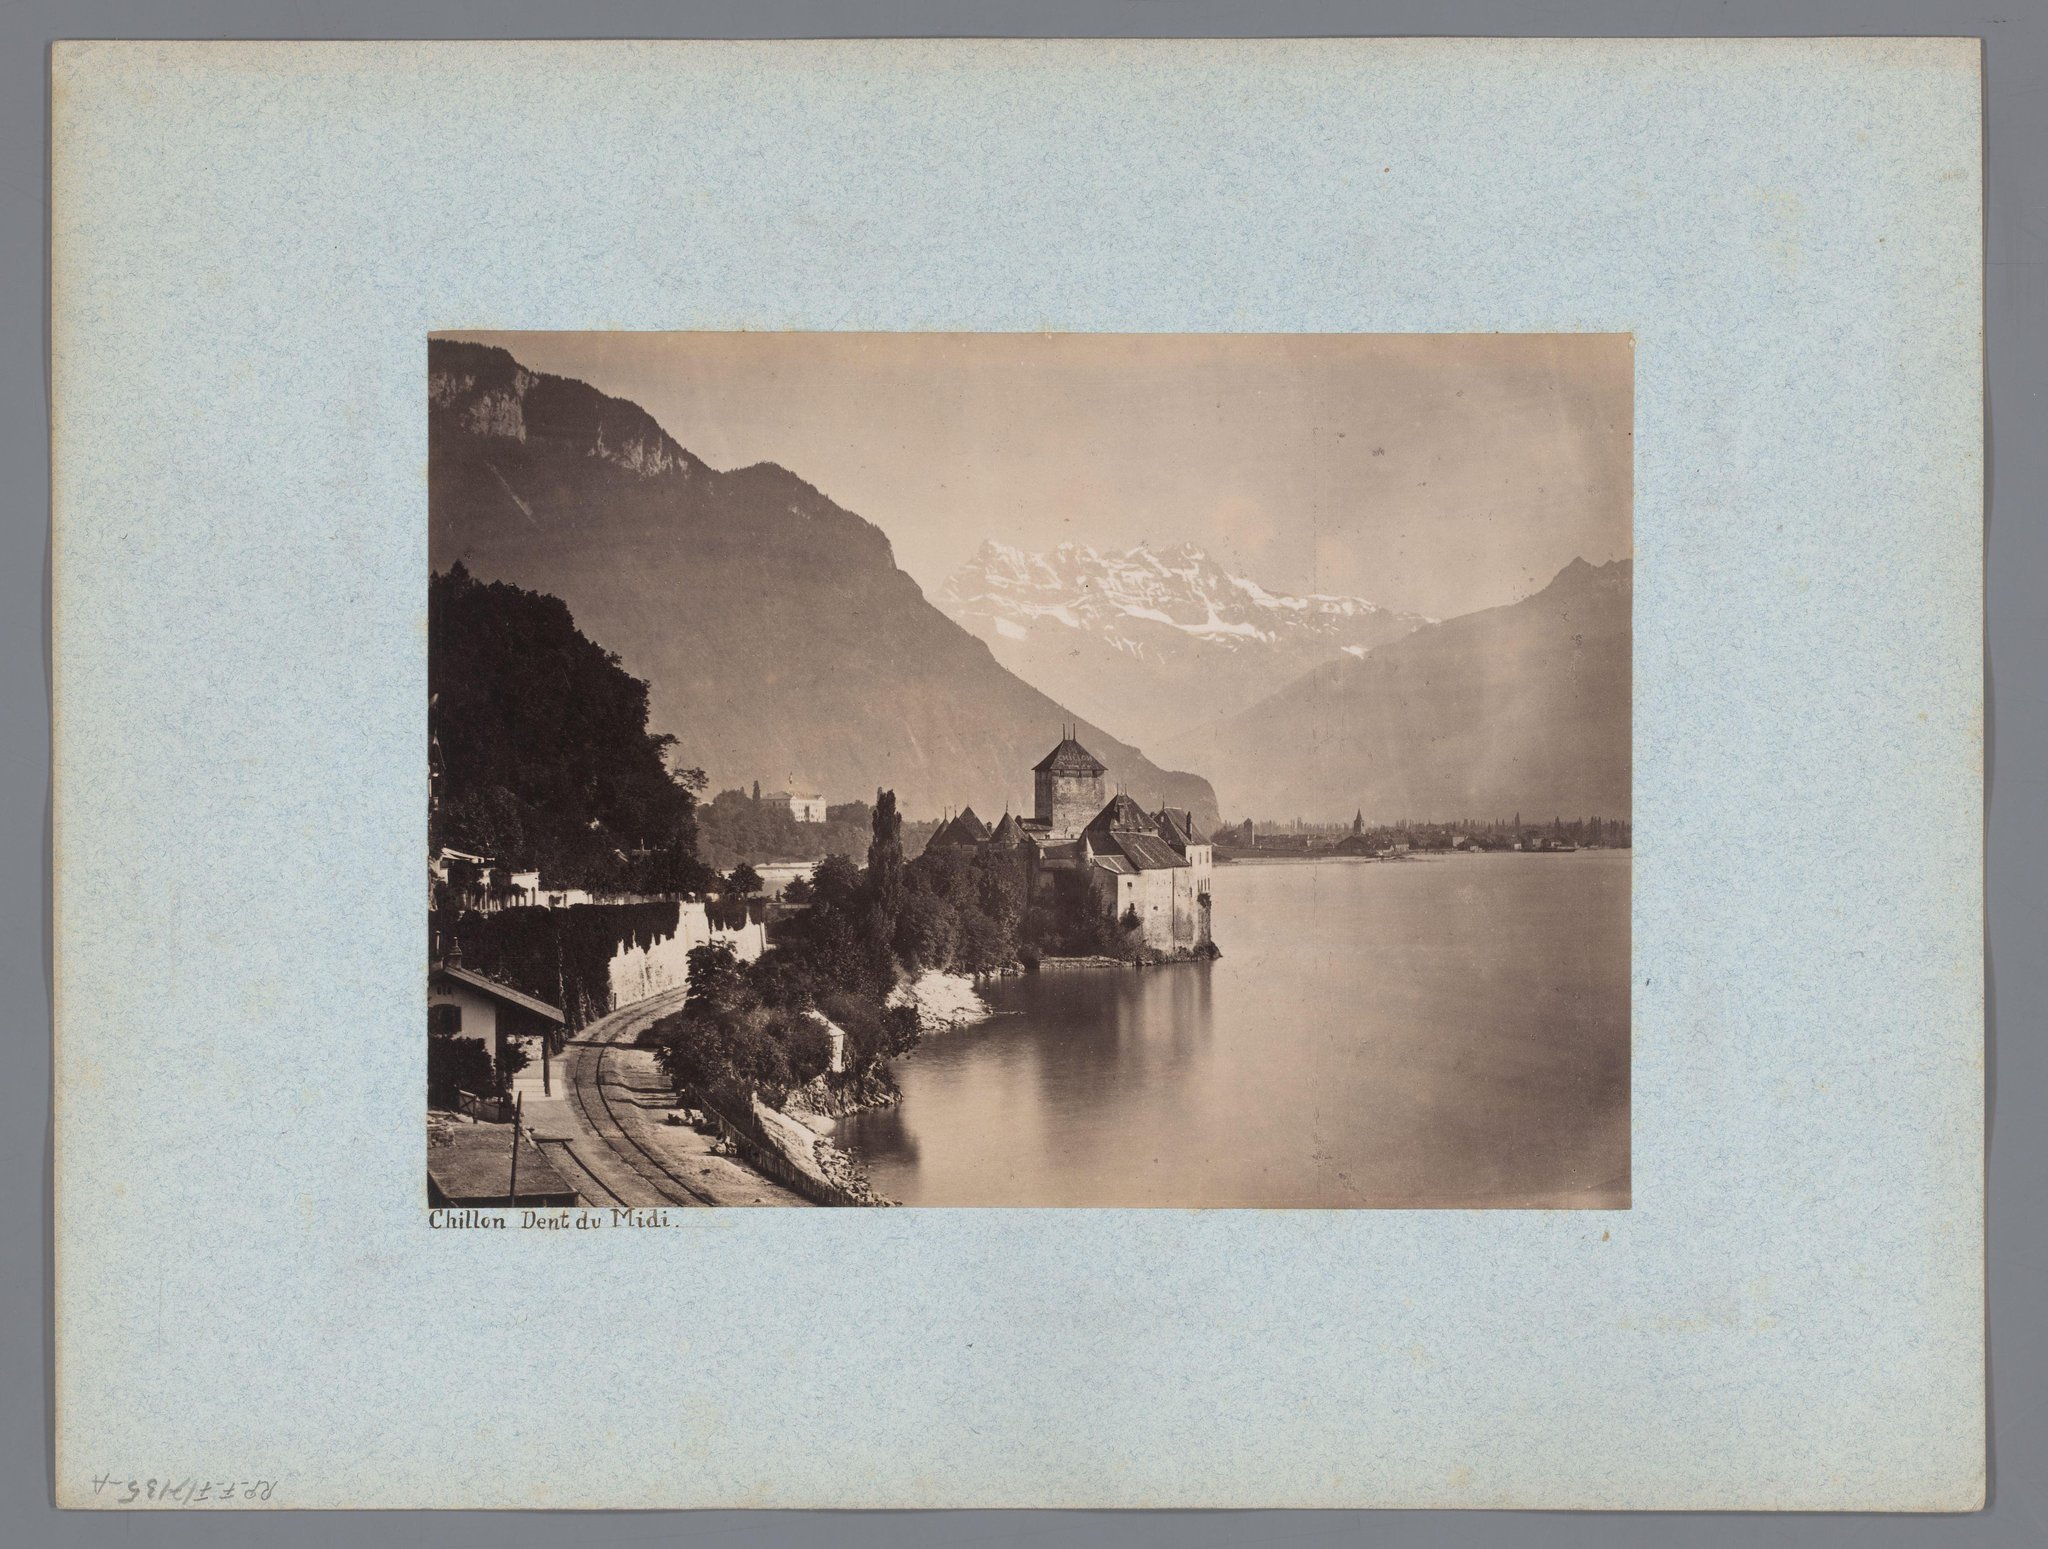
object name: photograph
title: Gezicht op kasteel Chillon en de Dents du Midi, Zwitserland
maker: Anonymous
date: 1851-1900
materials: cardboard, paper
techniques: albumen print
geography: lake geneva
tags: castle, lake, mountains